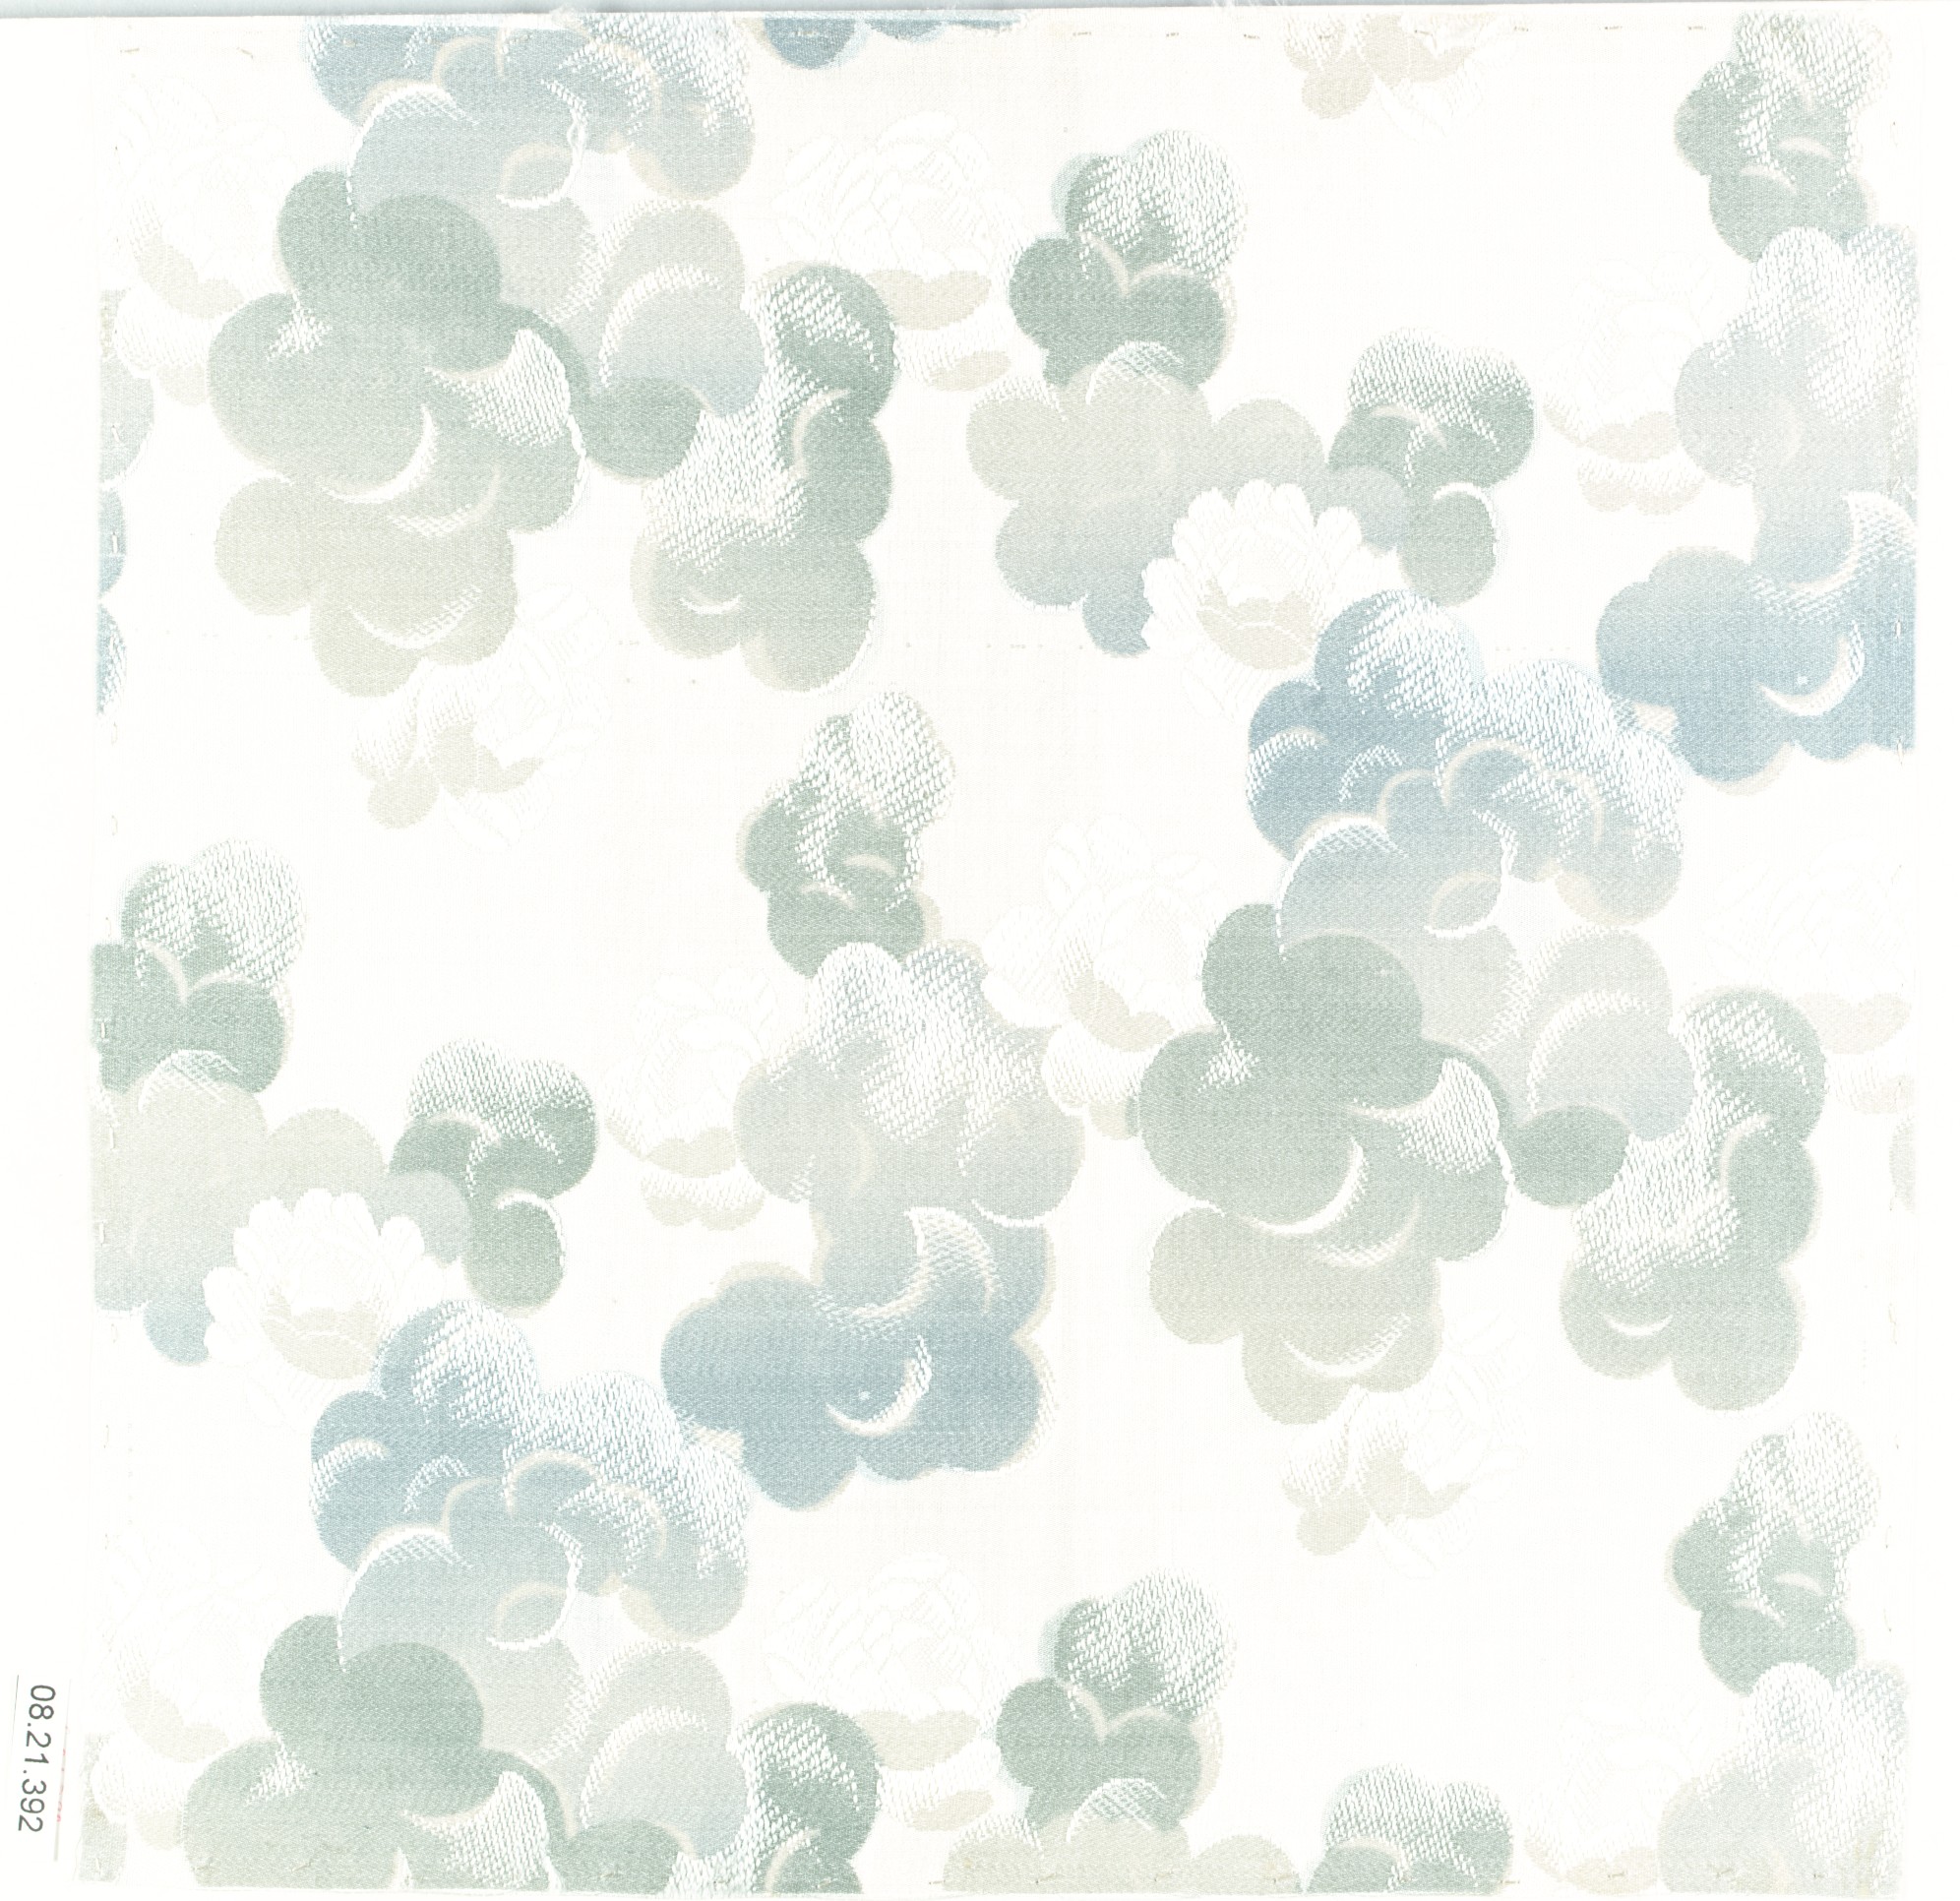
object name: textile sample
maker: Anonymous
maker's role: designer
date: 1900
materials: silk